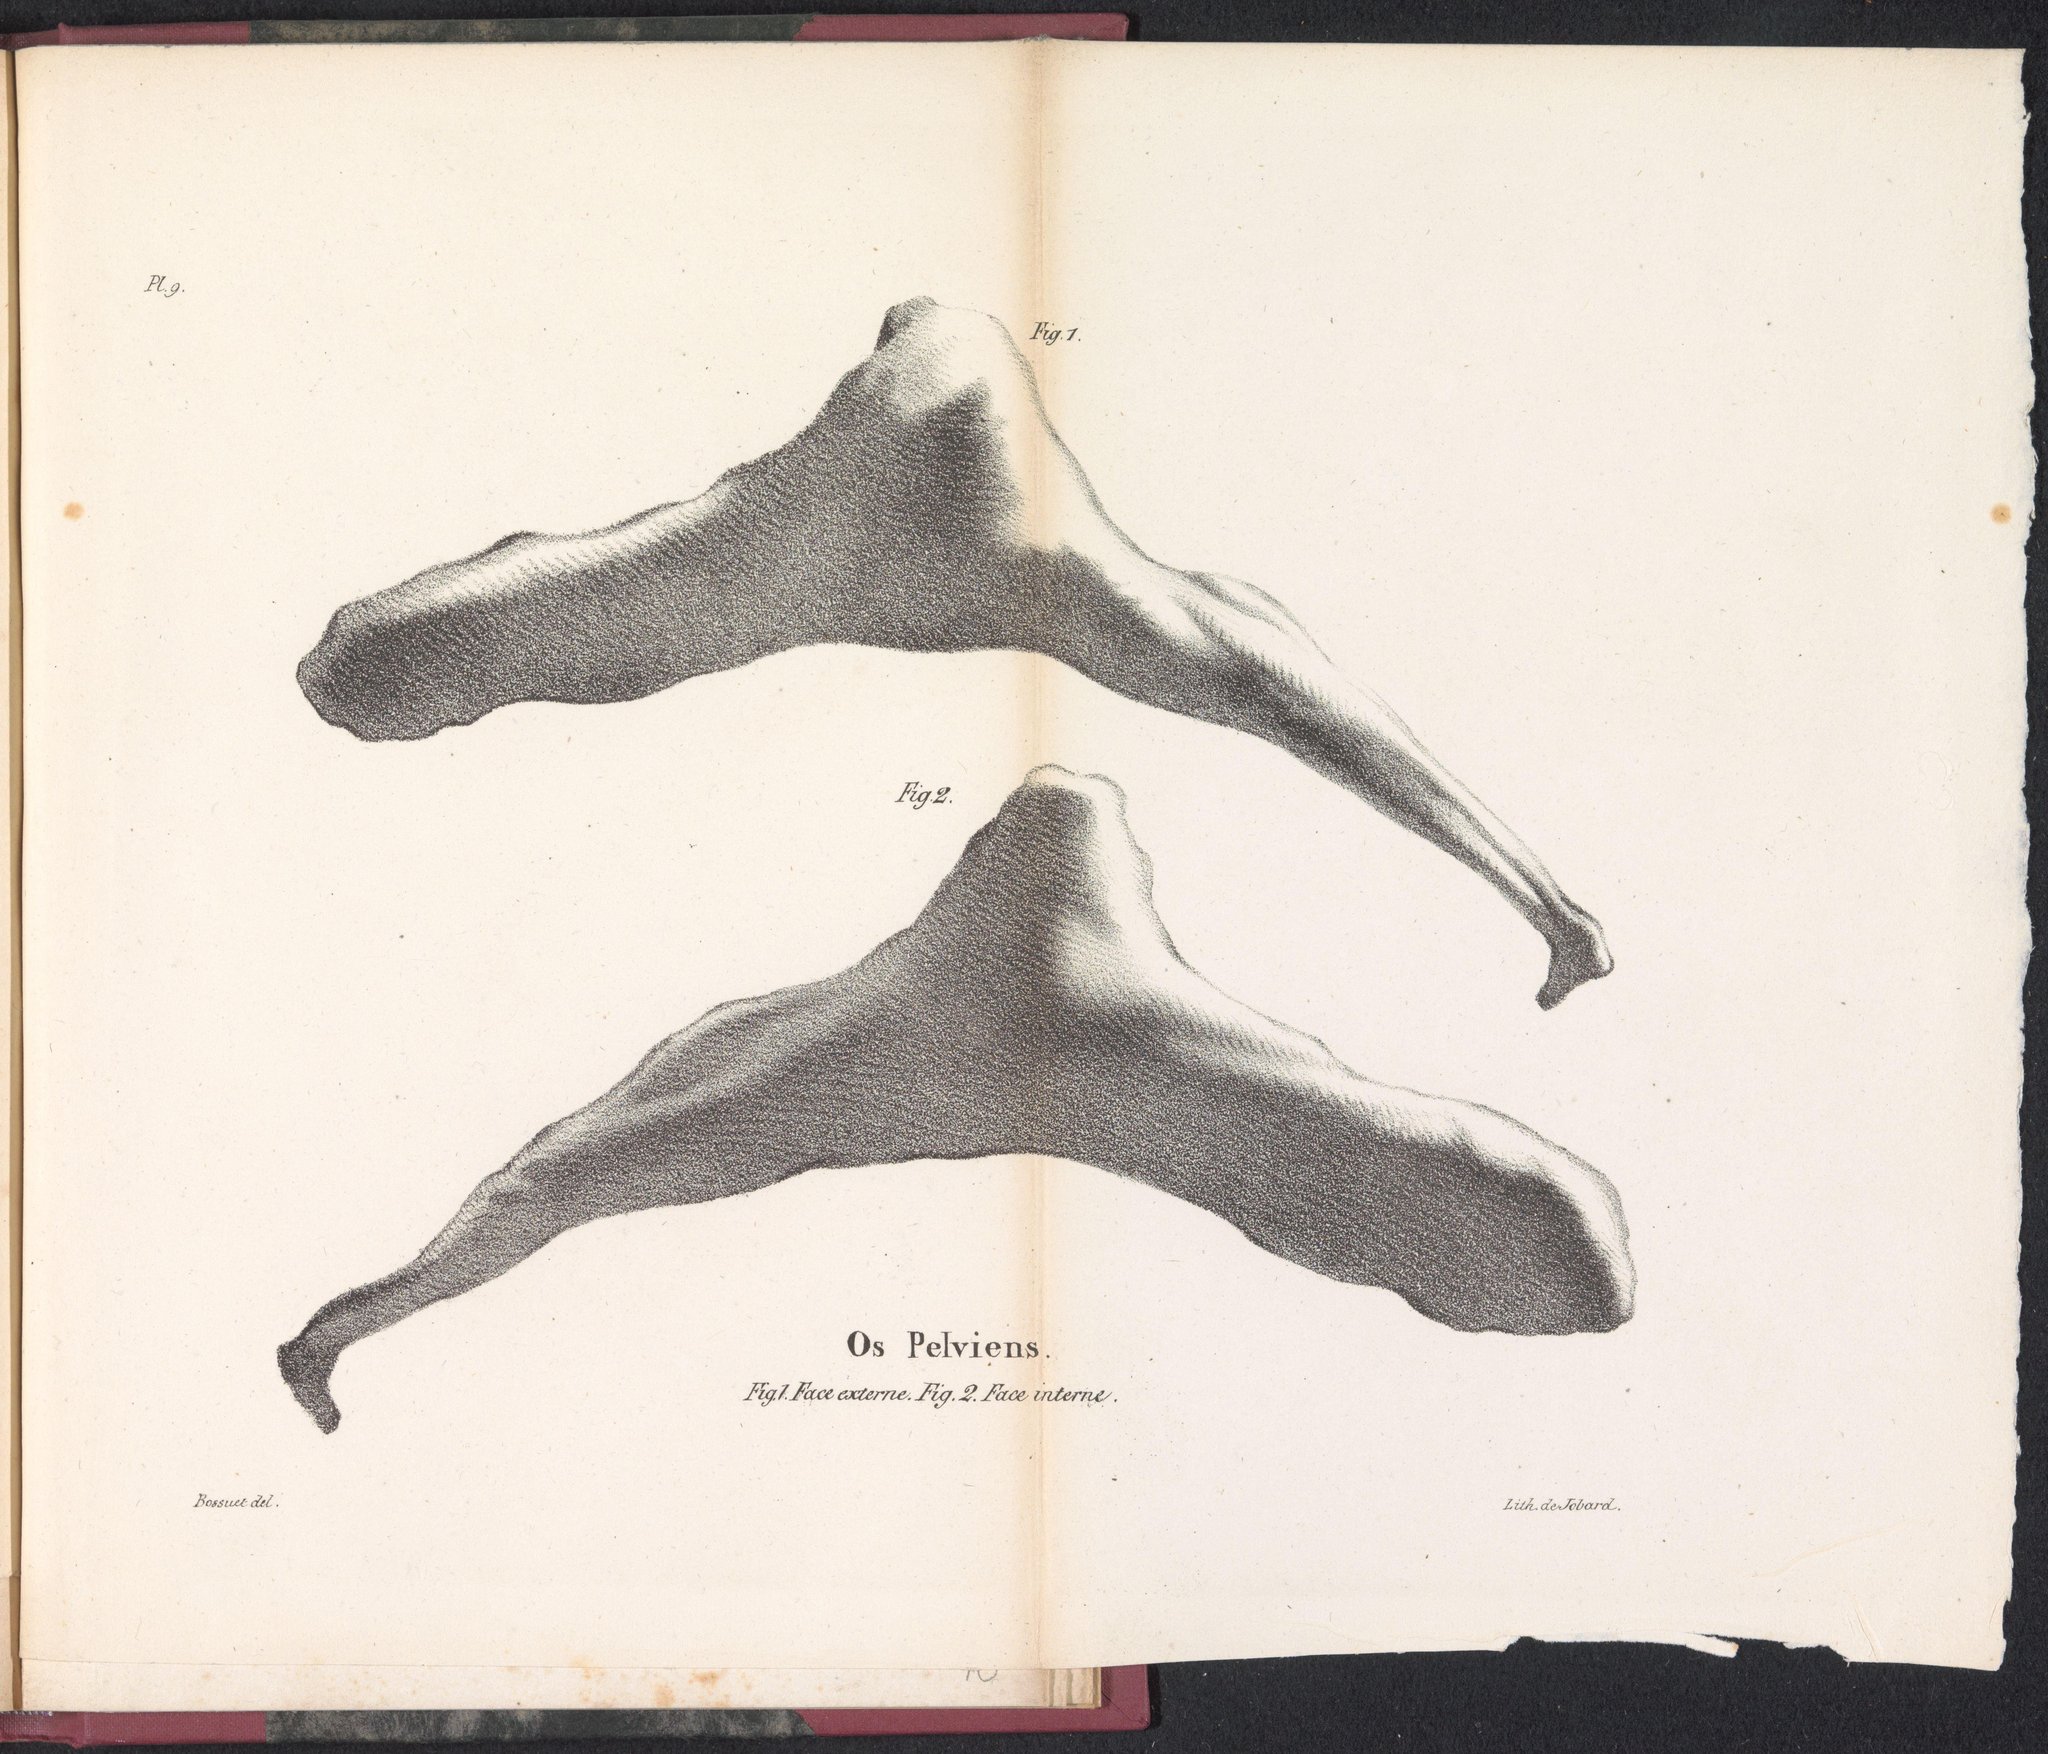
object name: print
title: Heupbeen van de walvis, 1827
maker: jean baptiste ambroise marcellin jobard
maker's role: print maker, publisher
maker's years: 1792-1861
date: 1828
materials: paper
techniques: lithograph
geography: brussels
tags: herman kessels, swimming mammals: whale (+ dying animal; death of animal; dead animal)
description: Twee aanzichten van het heupbeen van de walvis. Illustratie in een publicatie over de walvis gestrand op 4 november 1827 bij Oostende. De walvis was eigendom van H. Kessels en J. Dubar.